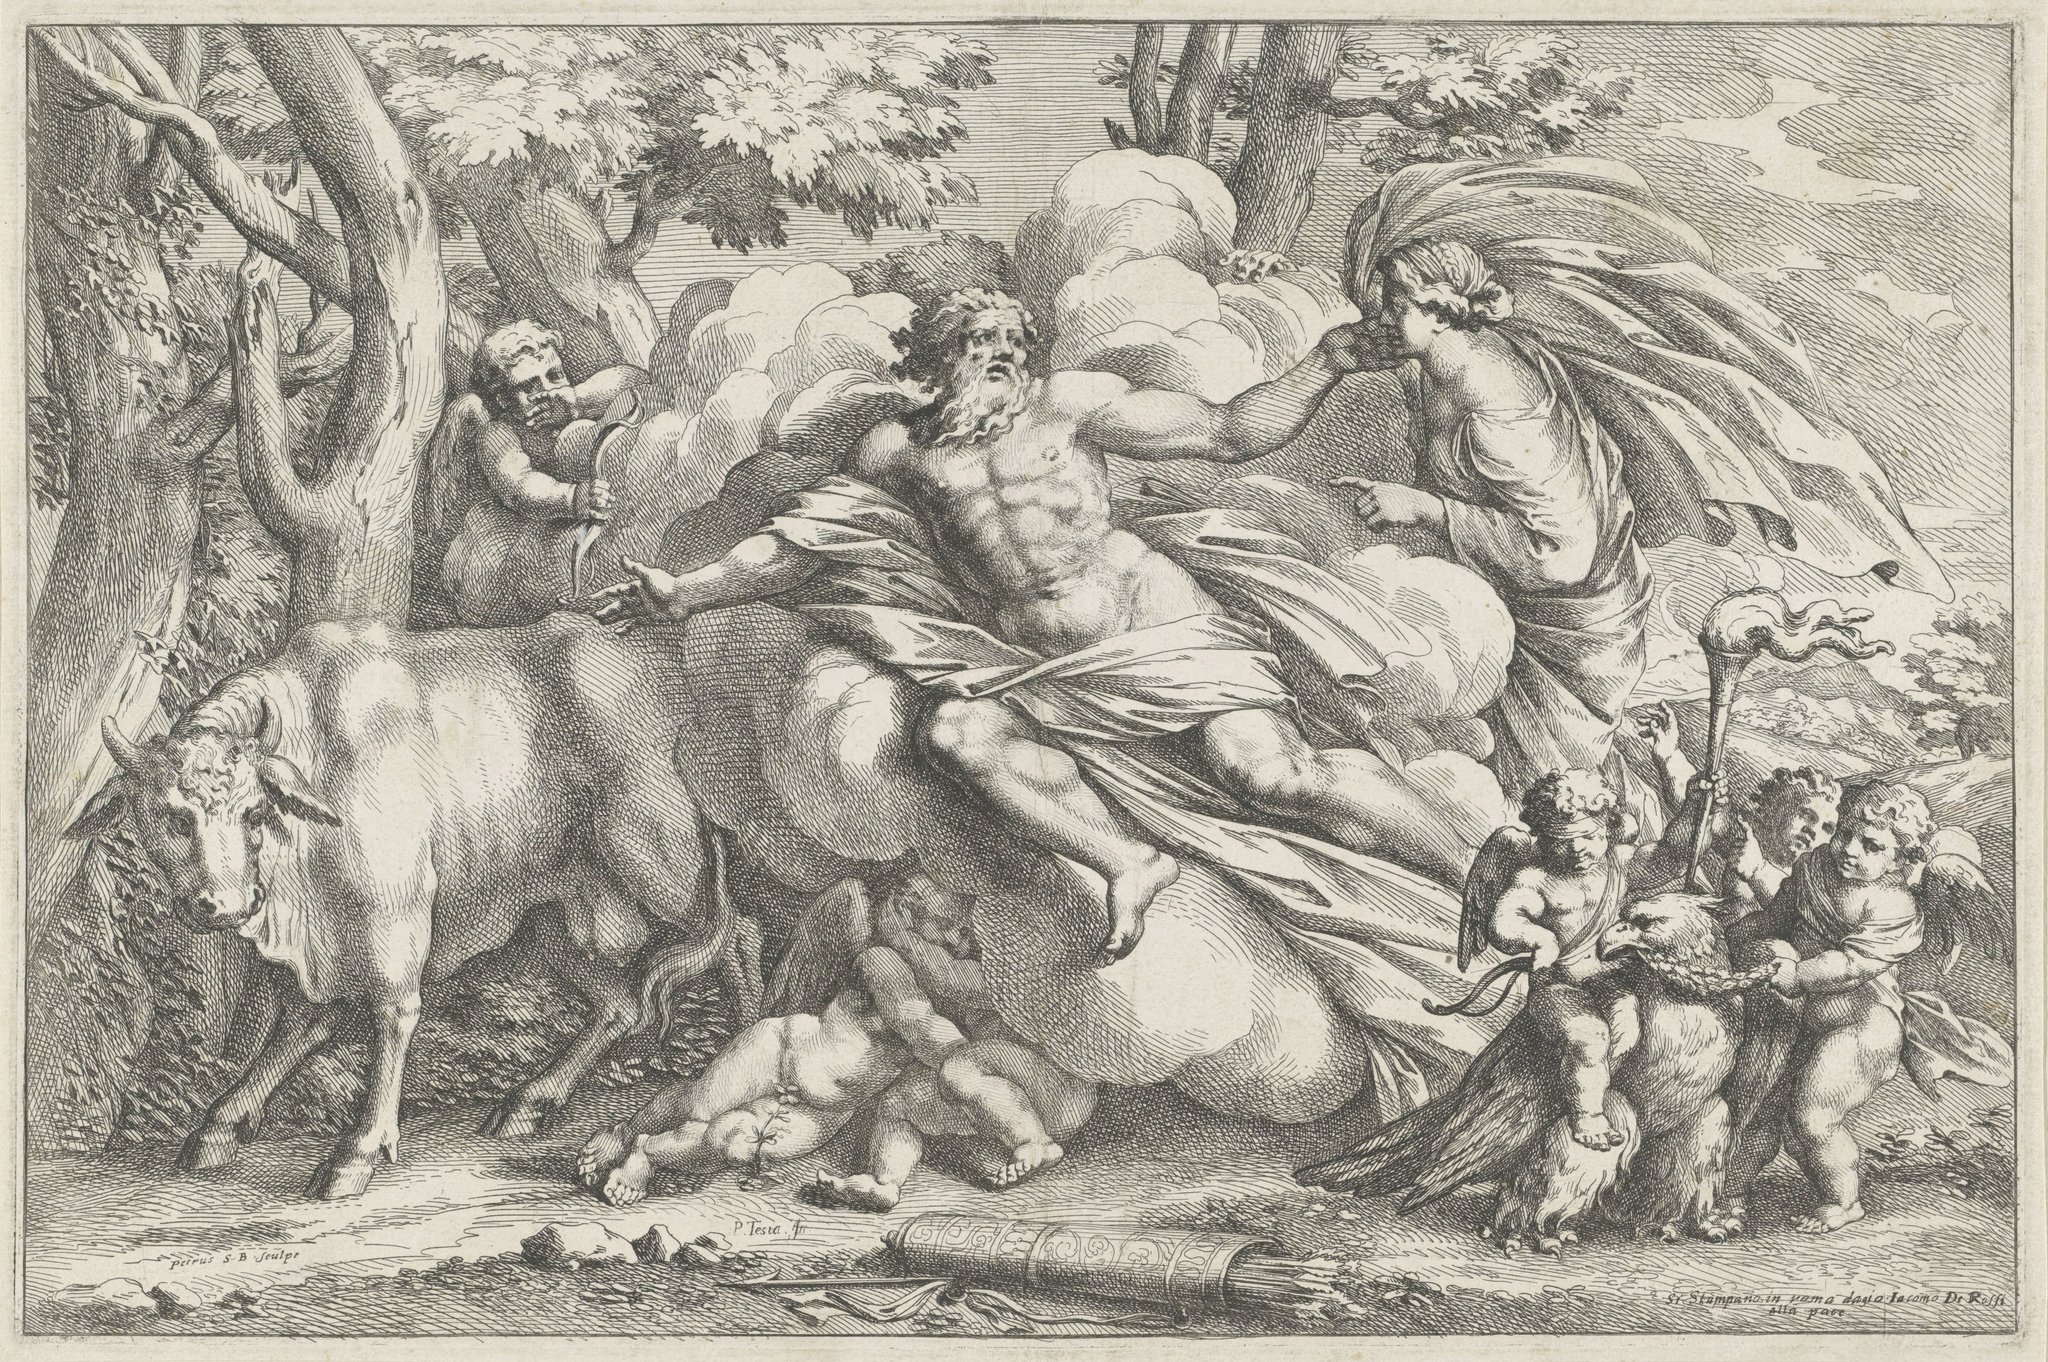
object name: print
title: Jupiter en Io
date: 1645-1700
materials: paper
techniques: engraving, etching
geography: rome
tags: io changed into a cow: to avoid detection by juno, jupiter changes io into a cow (ovid, metamorphoses i 611)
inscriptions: collector's mark: Lugt 240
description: Jupiter heeft Io in een koe veranderd. Rechts Juno die Jupiter komt controleren. Rechtsvoor een groep putti met een adelaar.